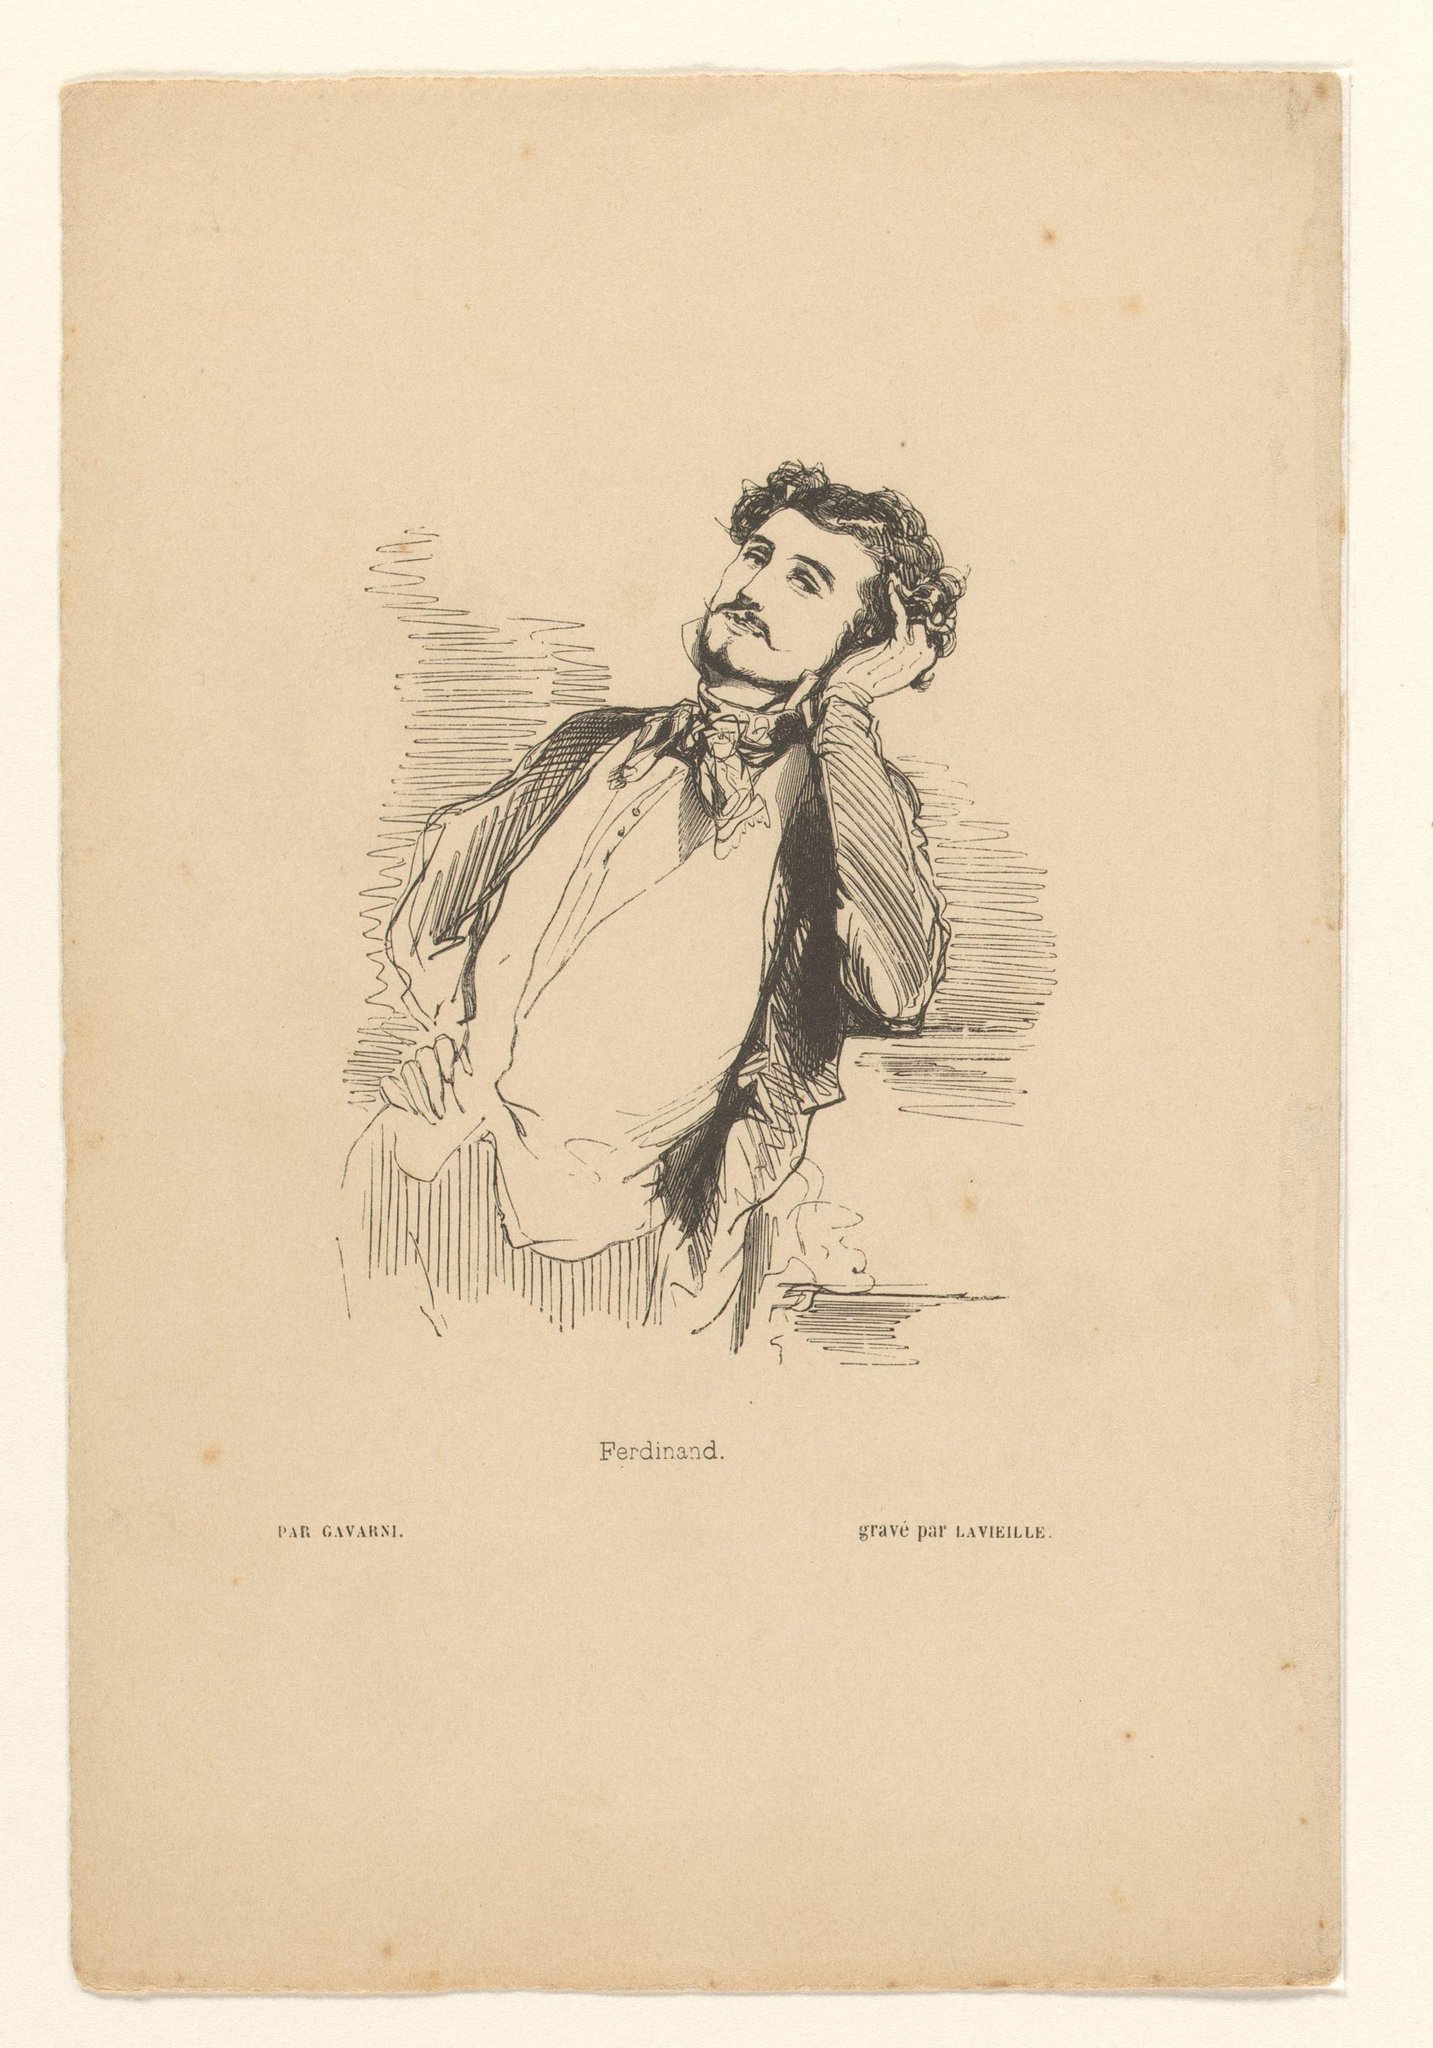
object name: print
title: Ferdinand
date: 1830-1862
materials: paper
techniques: engraving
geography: france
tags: paris, honoré de balzac, names of literary characters